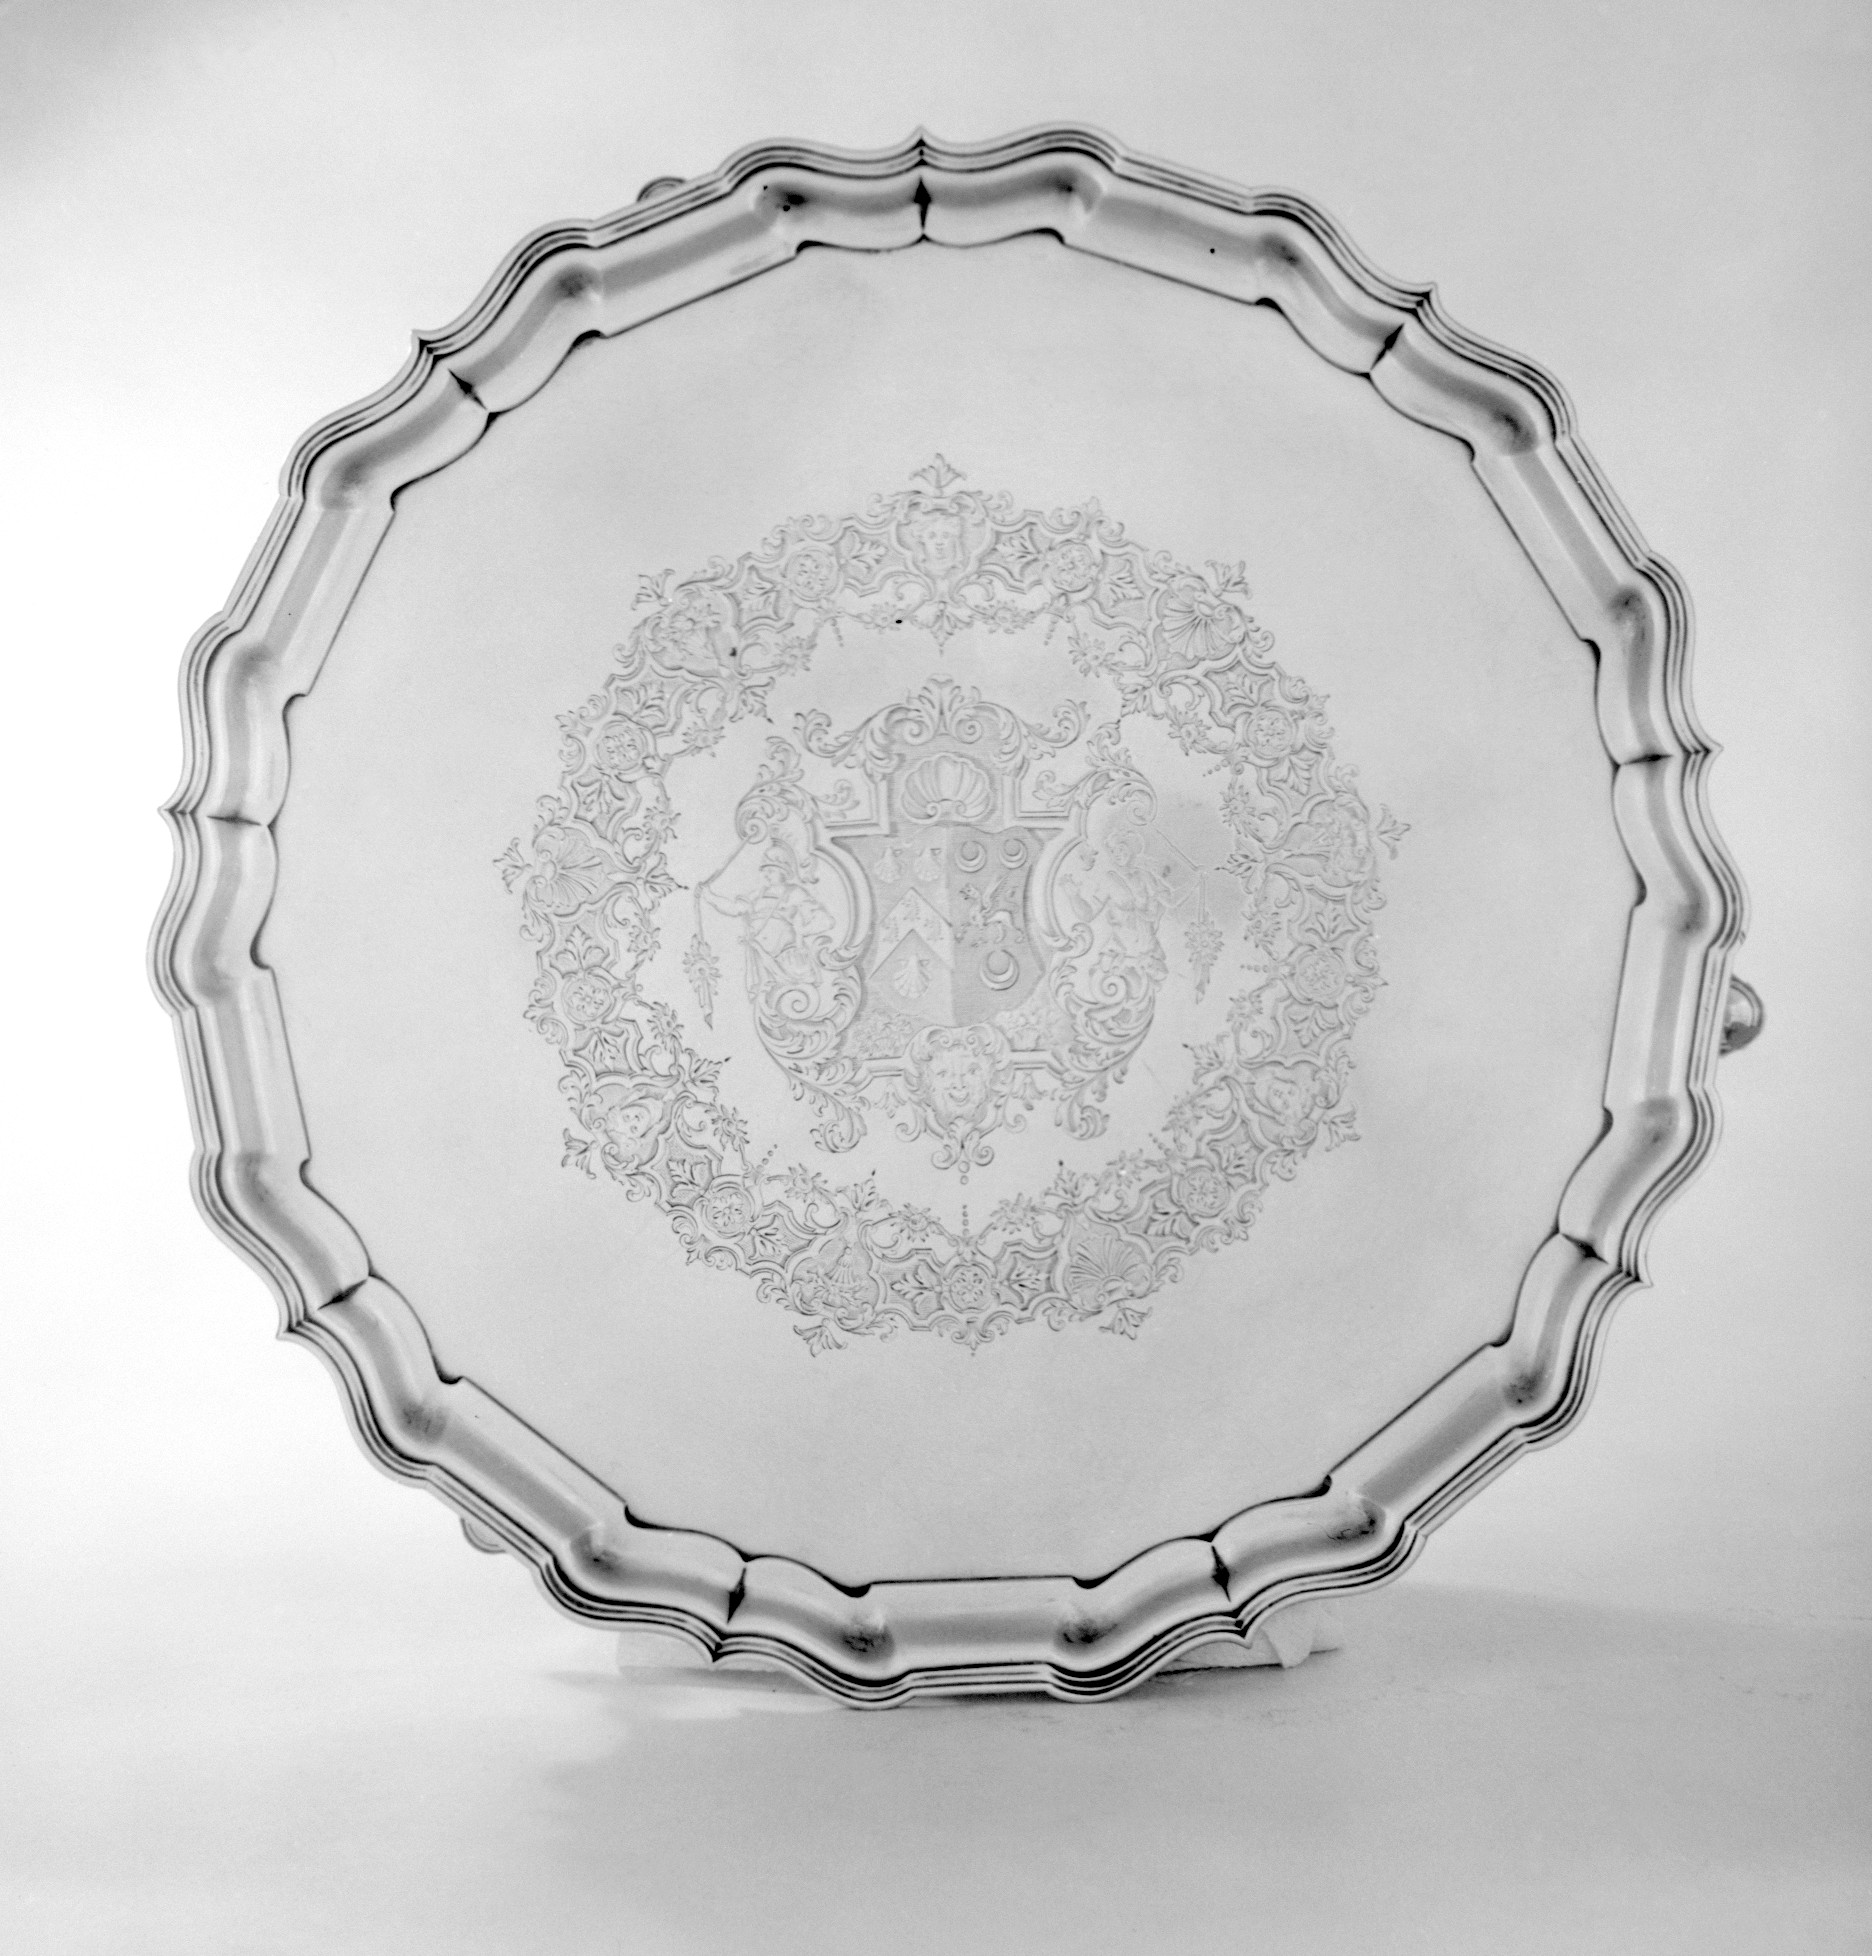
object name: salver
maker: augustin courtauld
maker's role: maker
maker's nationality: british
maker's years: 1685-1751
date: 1730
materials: silver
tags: coat of arms